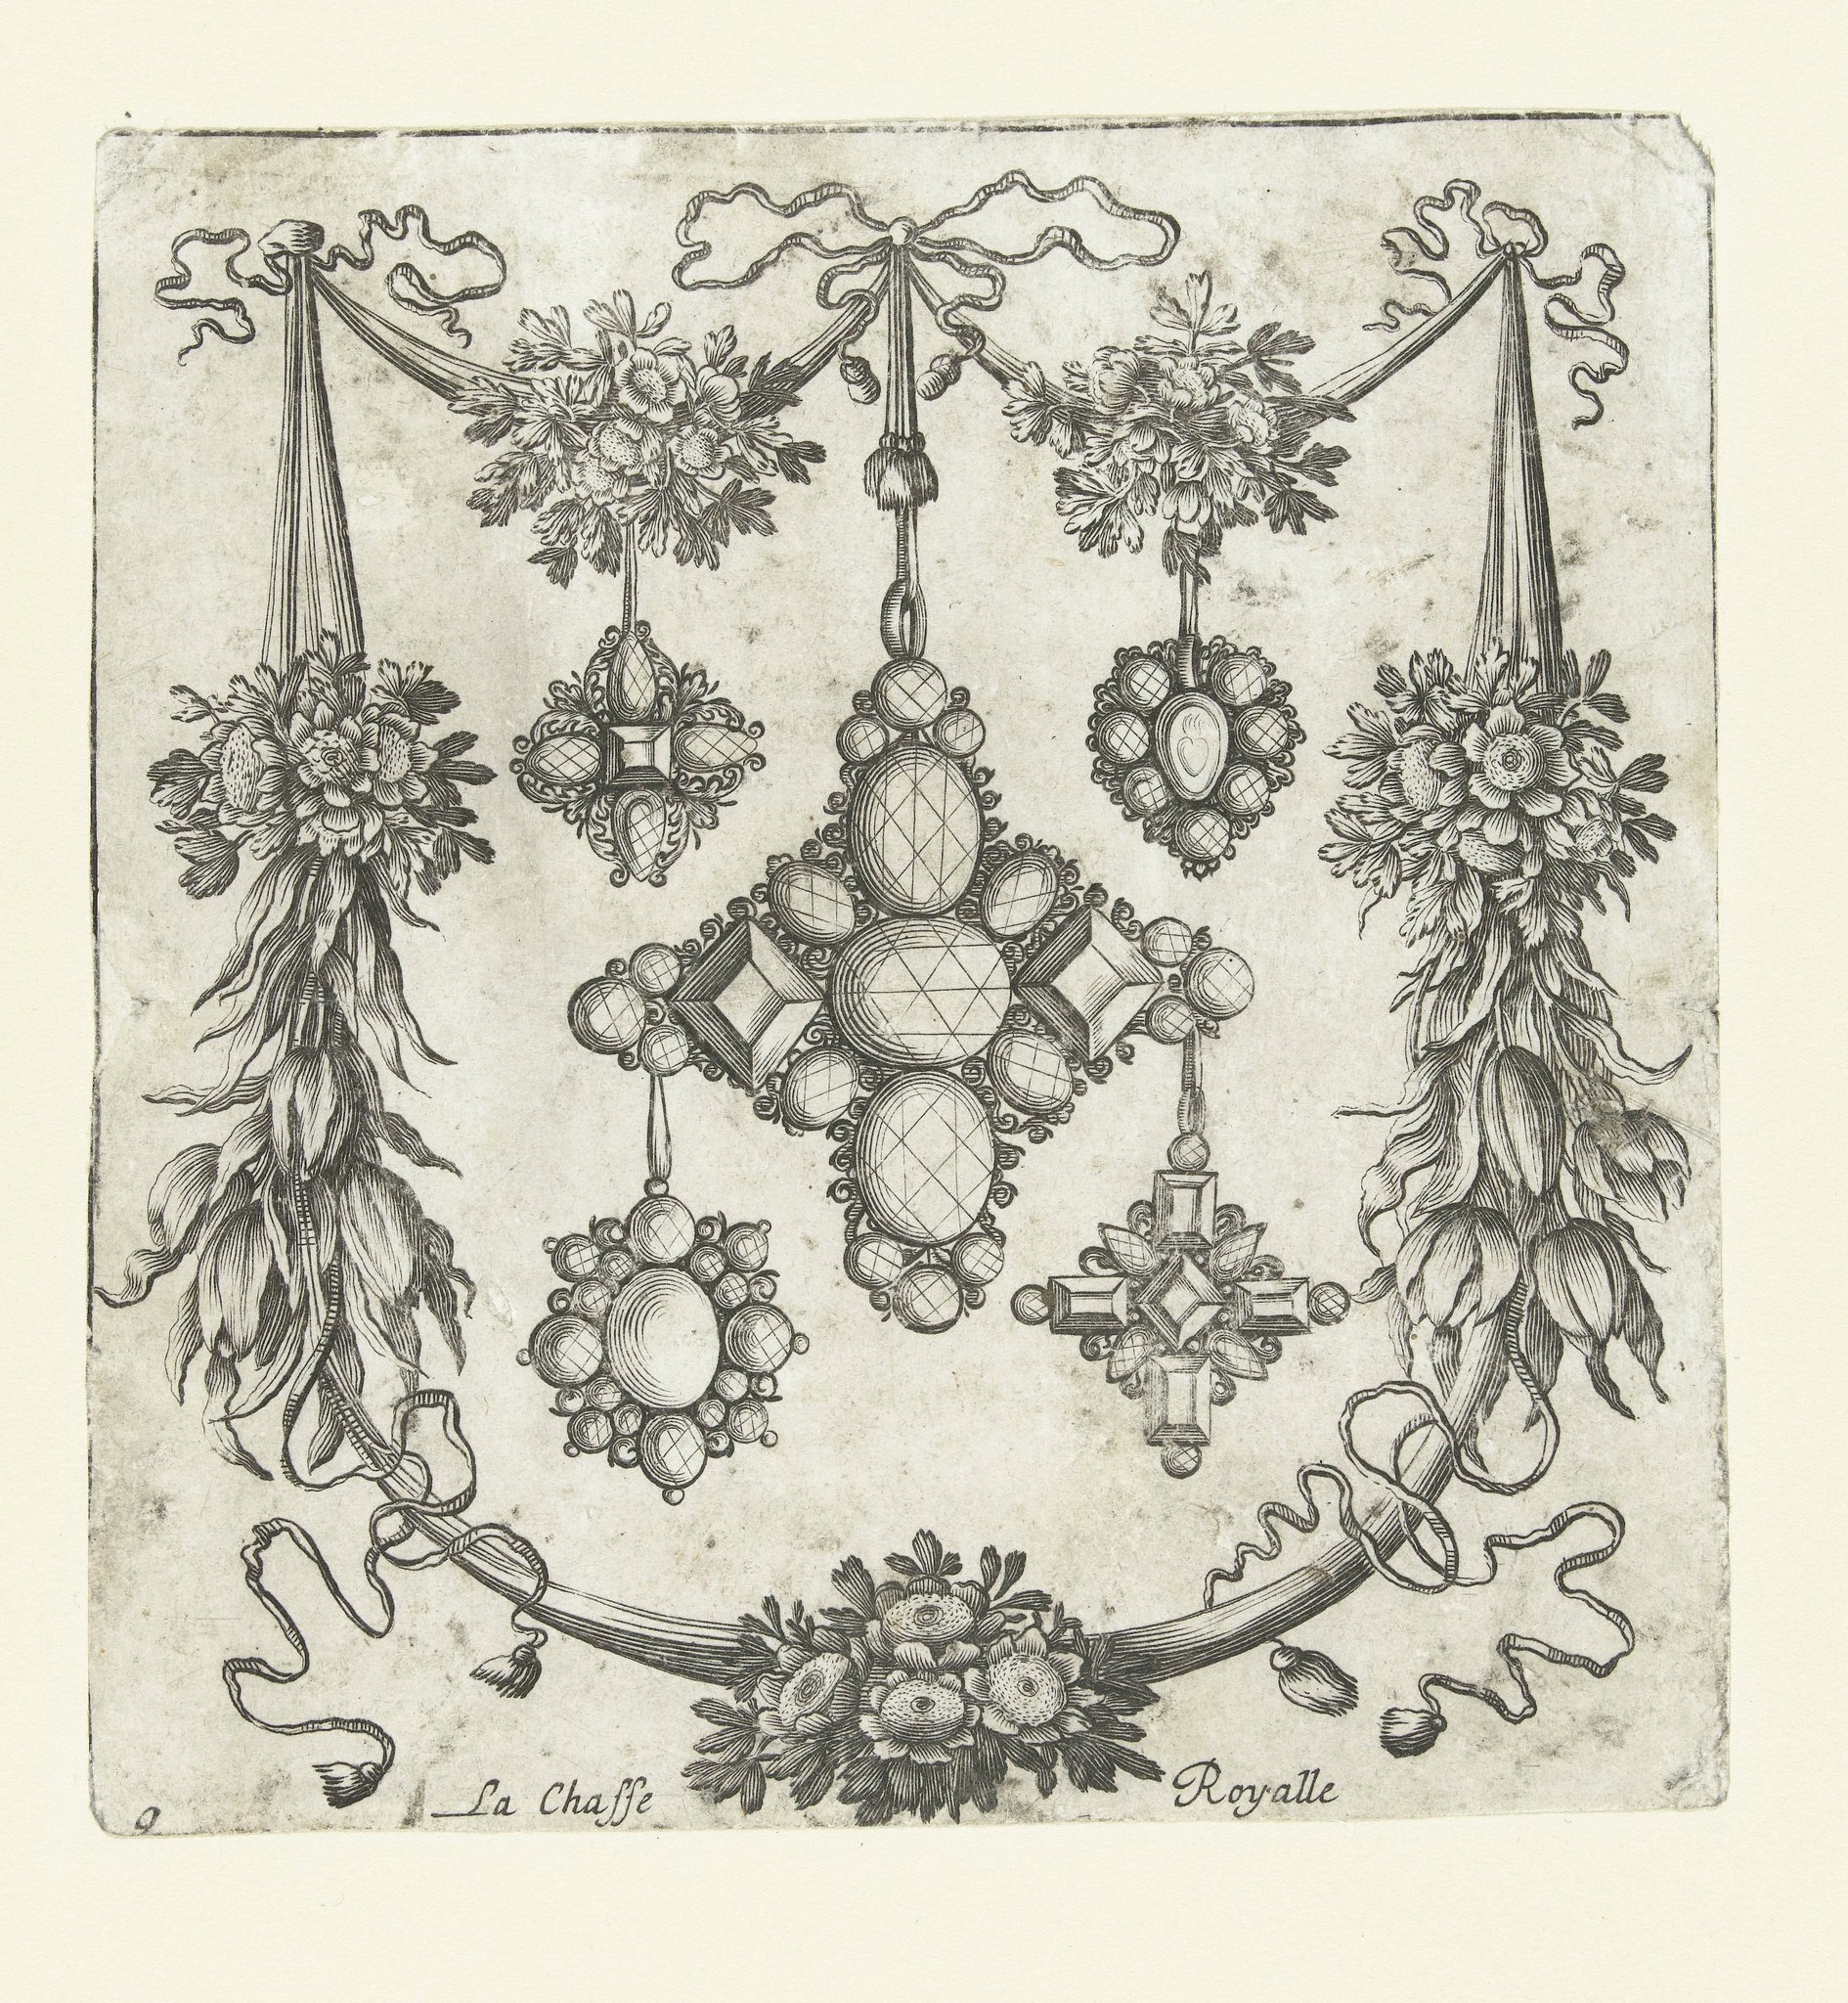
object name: ornament print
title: La Chasse Royalle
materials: paper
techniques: engraving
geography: paris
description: Cartouche opgebouwd uit bloemenfestoenen en linten, met in het midden een grote en vier kleine hangers. De koninklijke jachtpartij onderaan is afgesneden. Uit serie van 12 bladen met ontwerpen van juwelen voor goudsmeden en emailleurs. Vijfde editie.